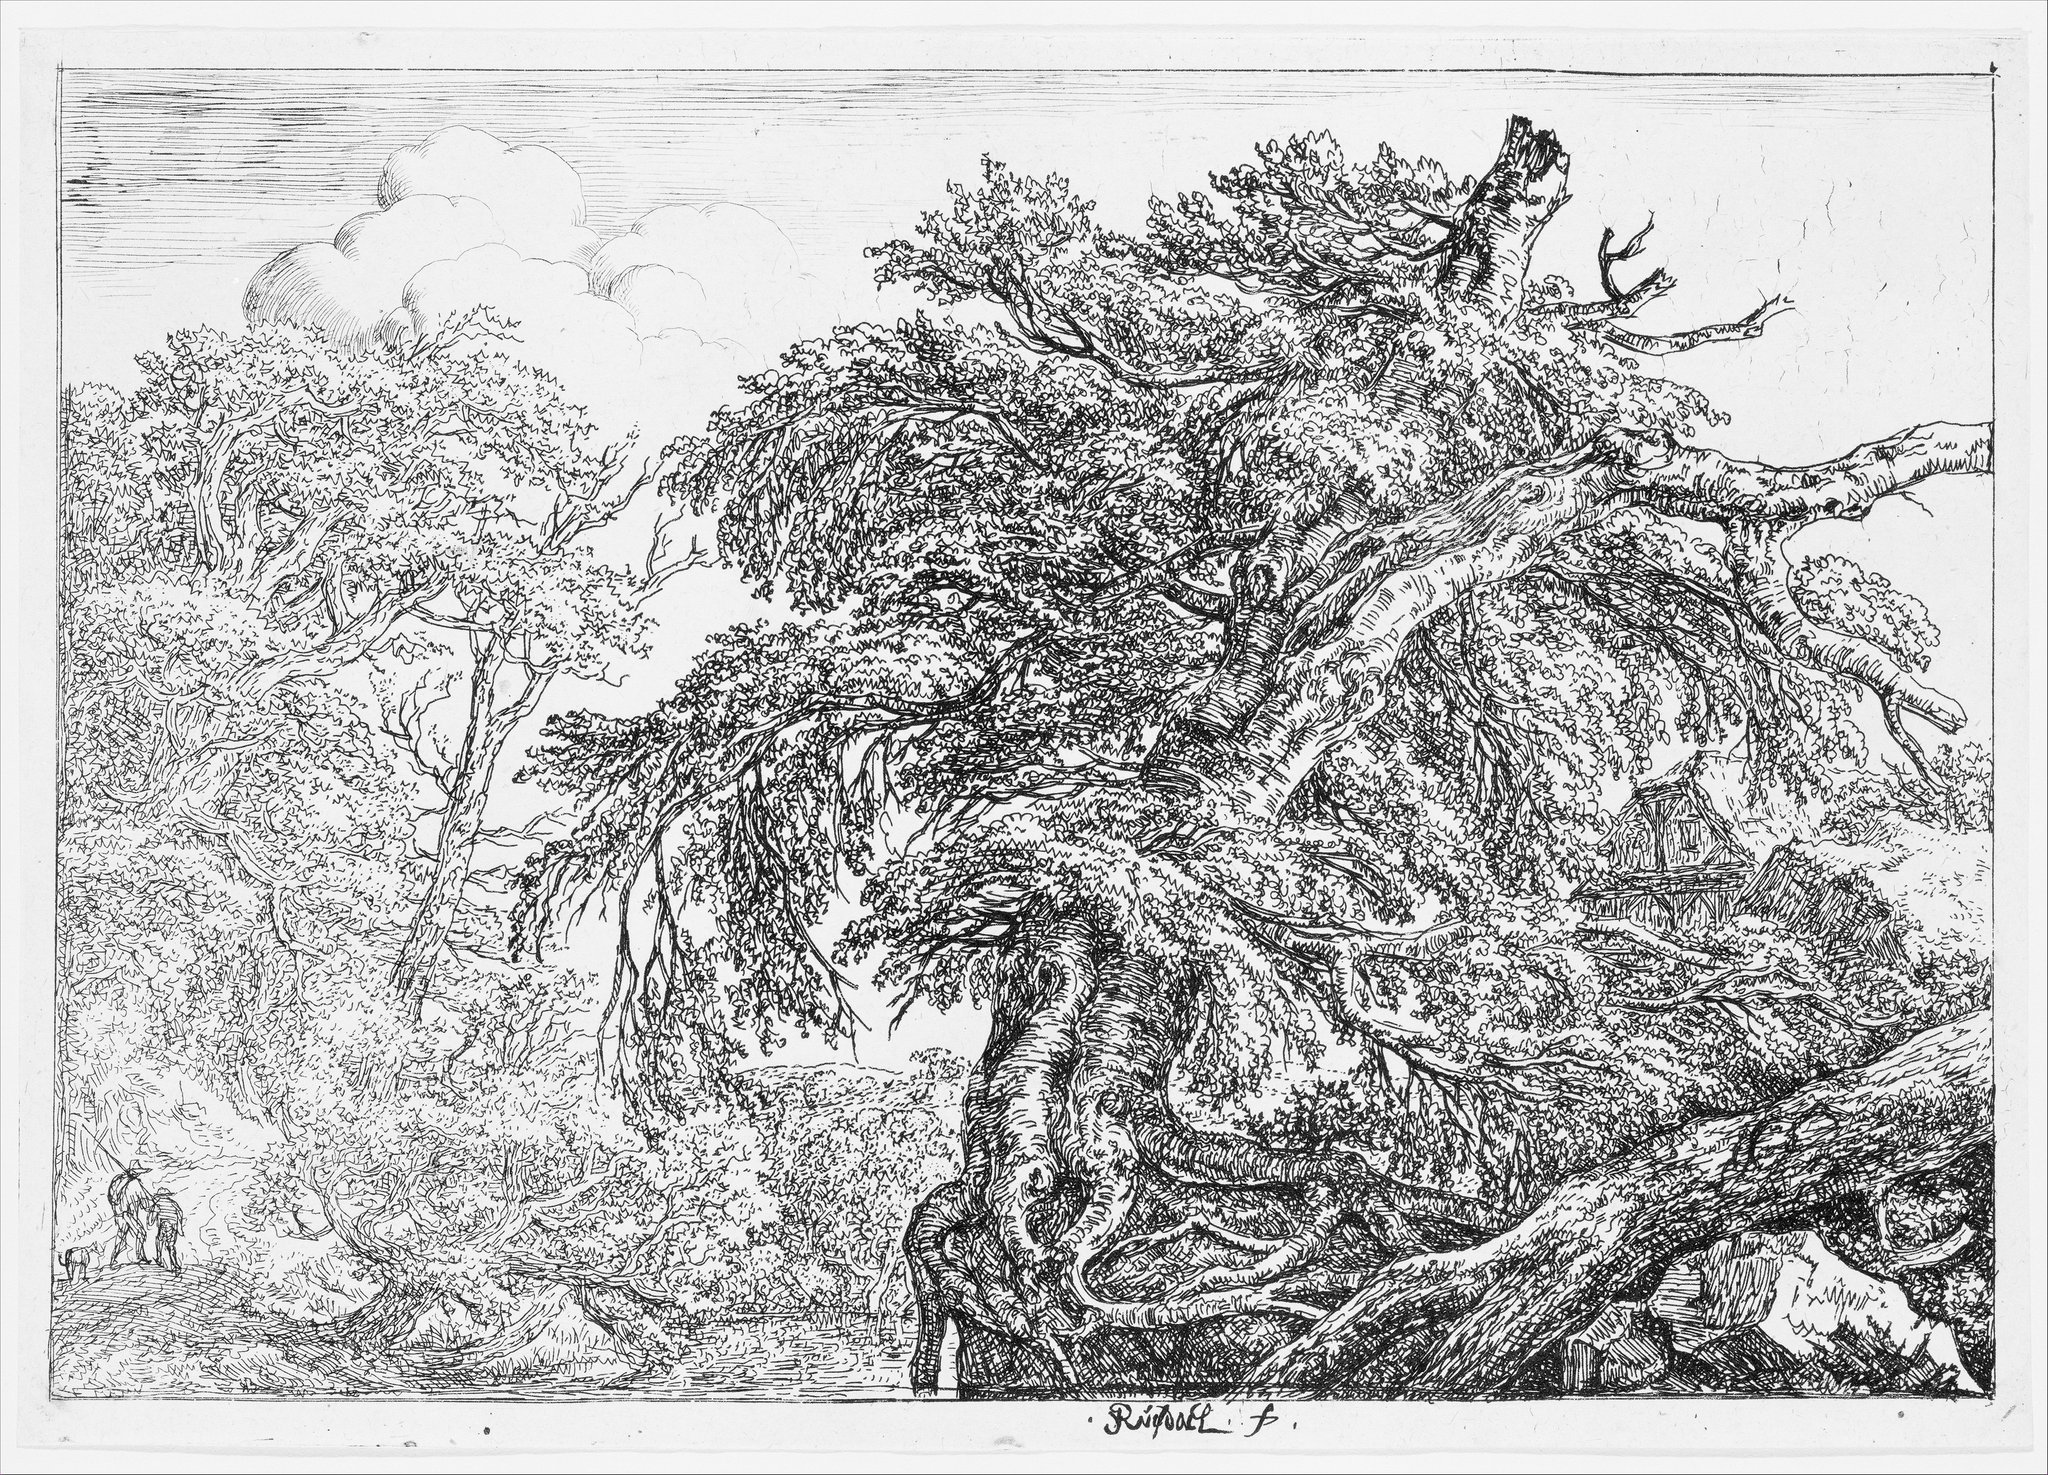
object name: print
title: The Great Beech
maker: jacob isaacksz van ruisdael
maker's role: artist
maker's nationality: dutch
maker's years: 1628-1682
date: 1650-1682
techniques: etching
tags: human figures,trees